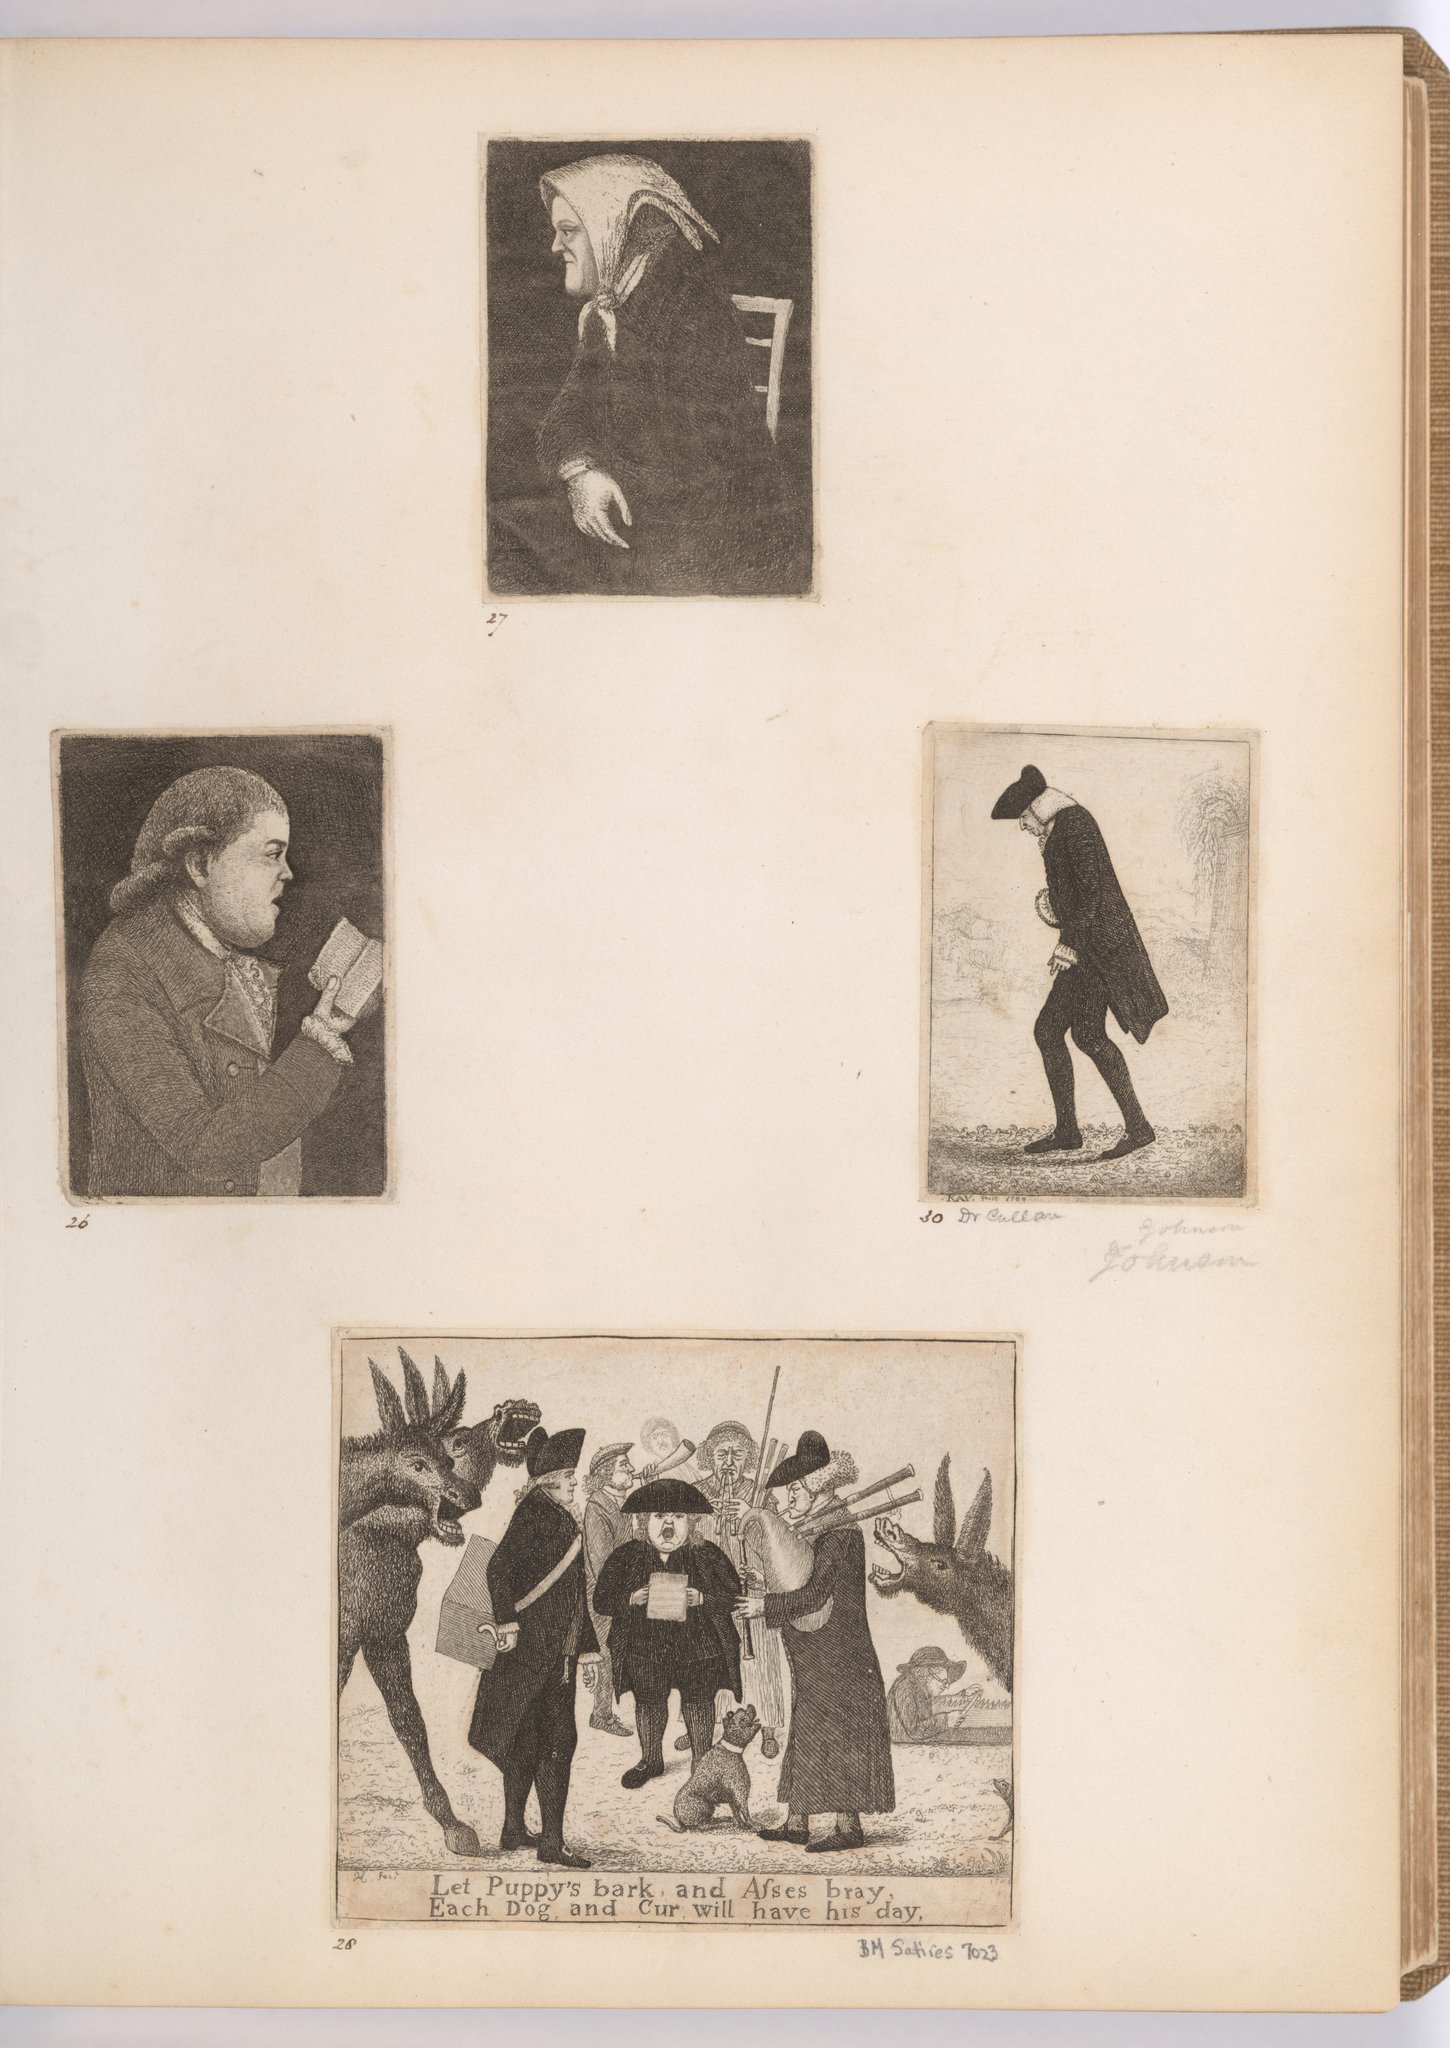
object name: print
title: Mr. Thomas Neil, Carpenter, and Precenter in the Old Church, Edinburgh, in the Character of "The Old Wife"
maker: john kay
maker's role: artist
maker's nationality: british, scottish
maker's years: 1742-1826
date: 1784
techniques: etching